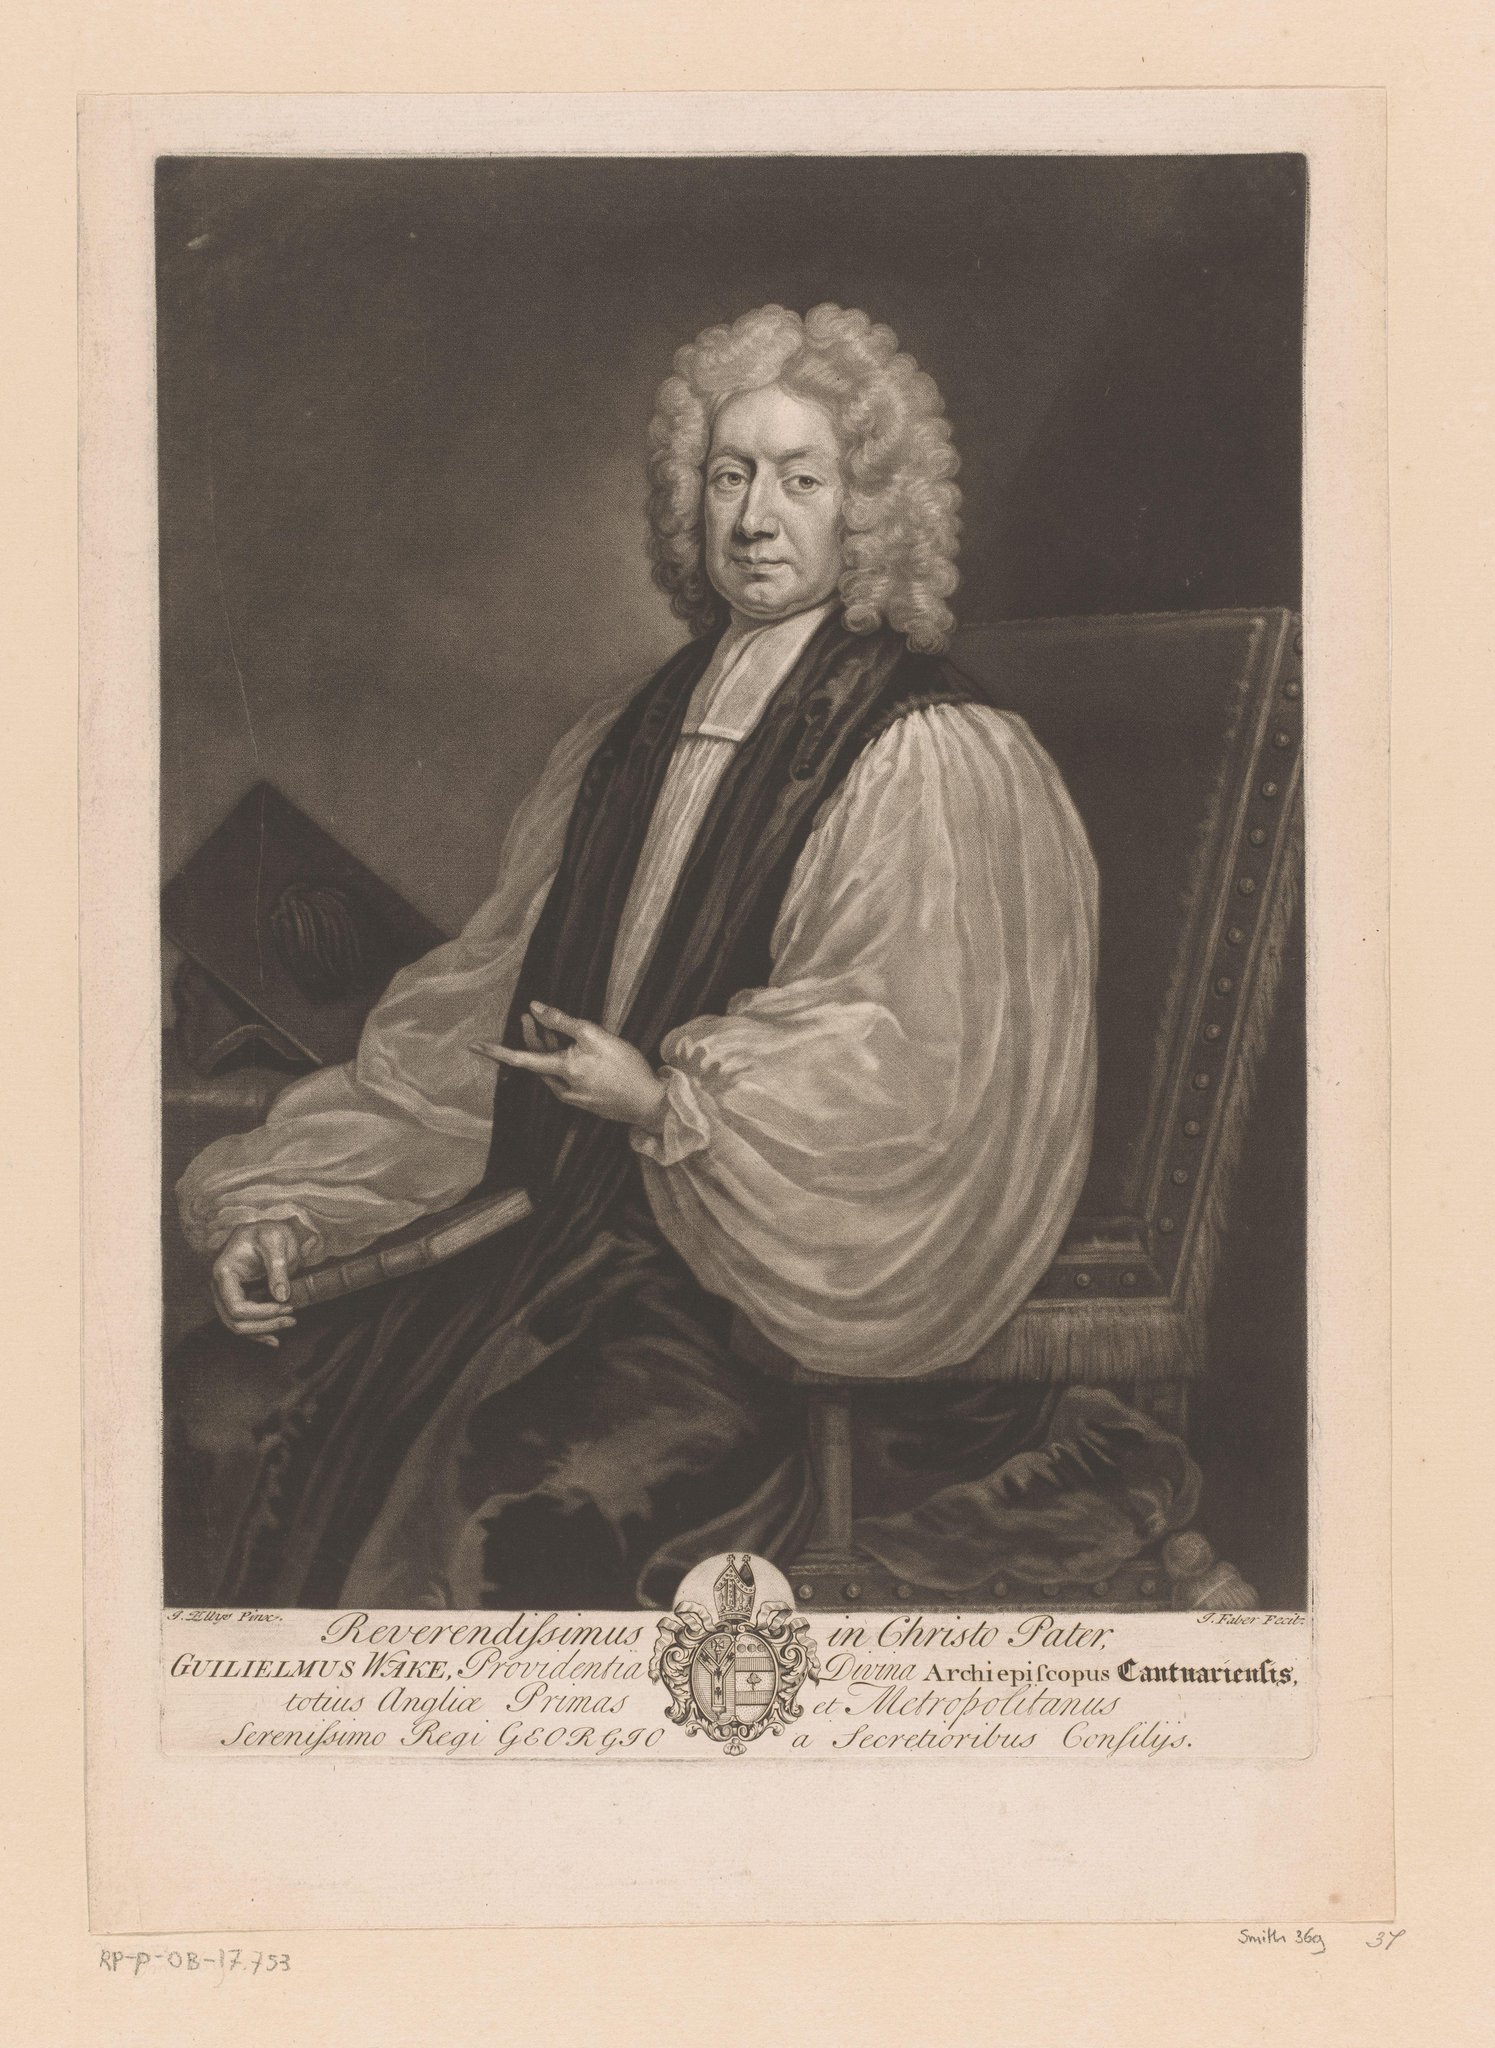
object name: print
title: Portret van William Wake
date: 1716-1756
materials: paper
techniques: etching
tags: archbishop, bishop, etc. (roman catholic), historical persons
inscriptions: collector's mark: Lugt 240